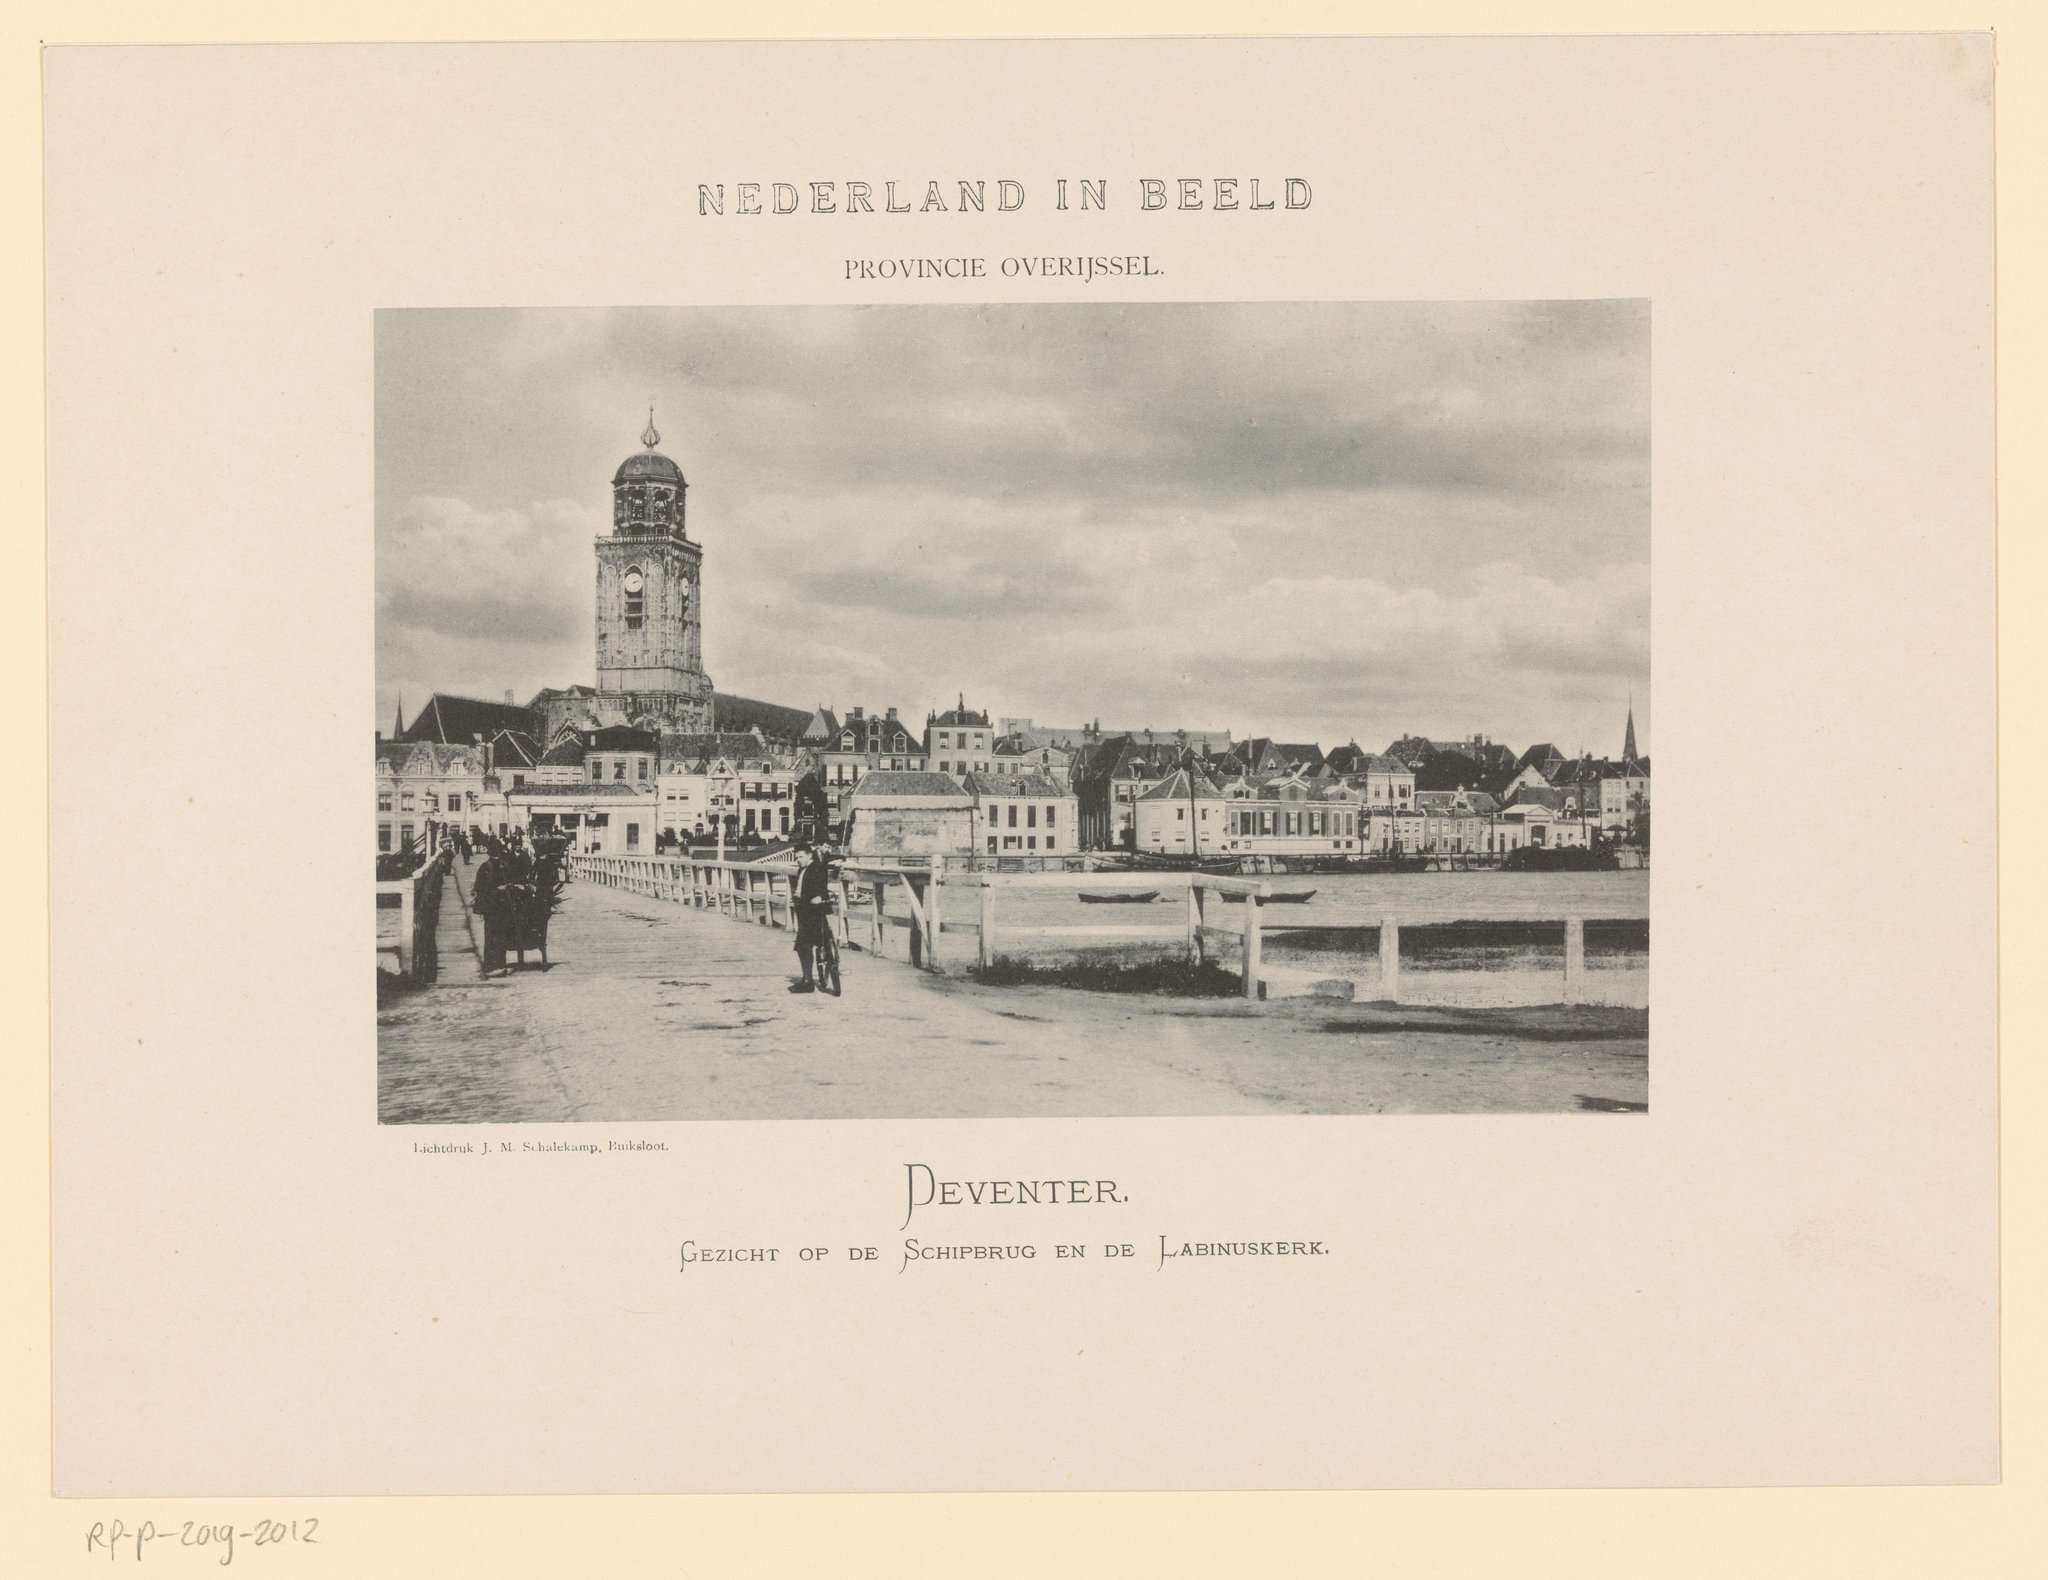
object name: photomechanical print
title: Gezichten in Nederland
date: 1896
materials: paper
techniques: photograph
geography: buiksloot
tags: church (exterior), canals, waters (in city) (+ city(-scape) with figures, staffage)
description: Afdruk uit: Nederland in Beeld. Buiksloot: J.M. Schalekamp, 1896.